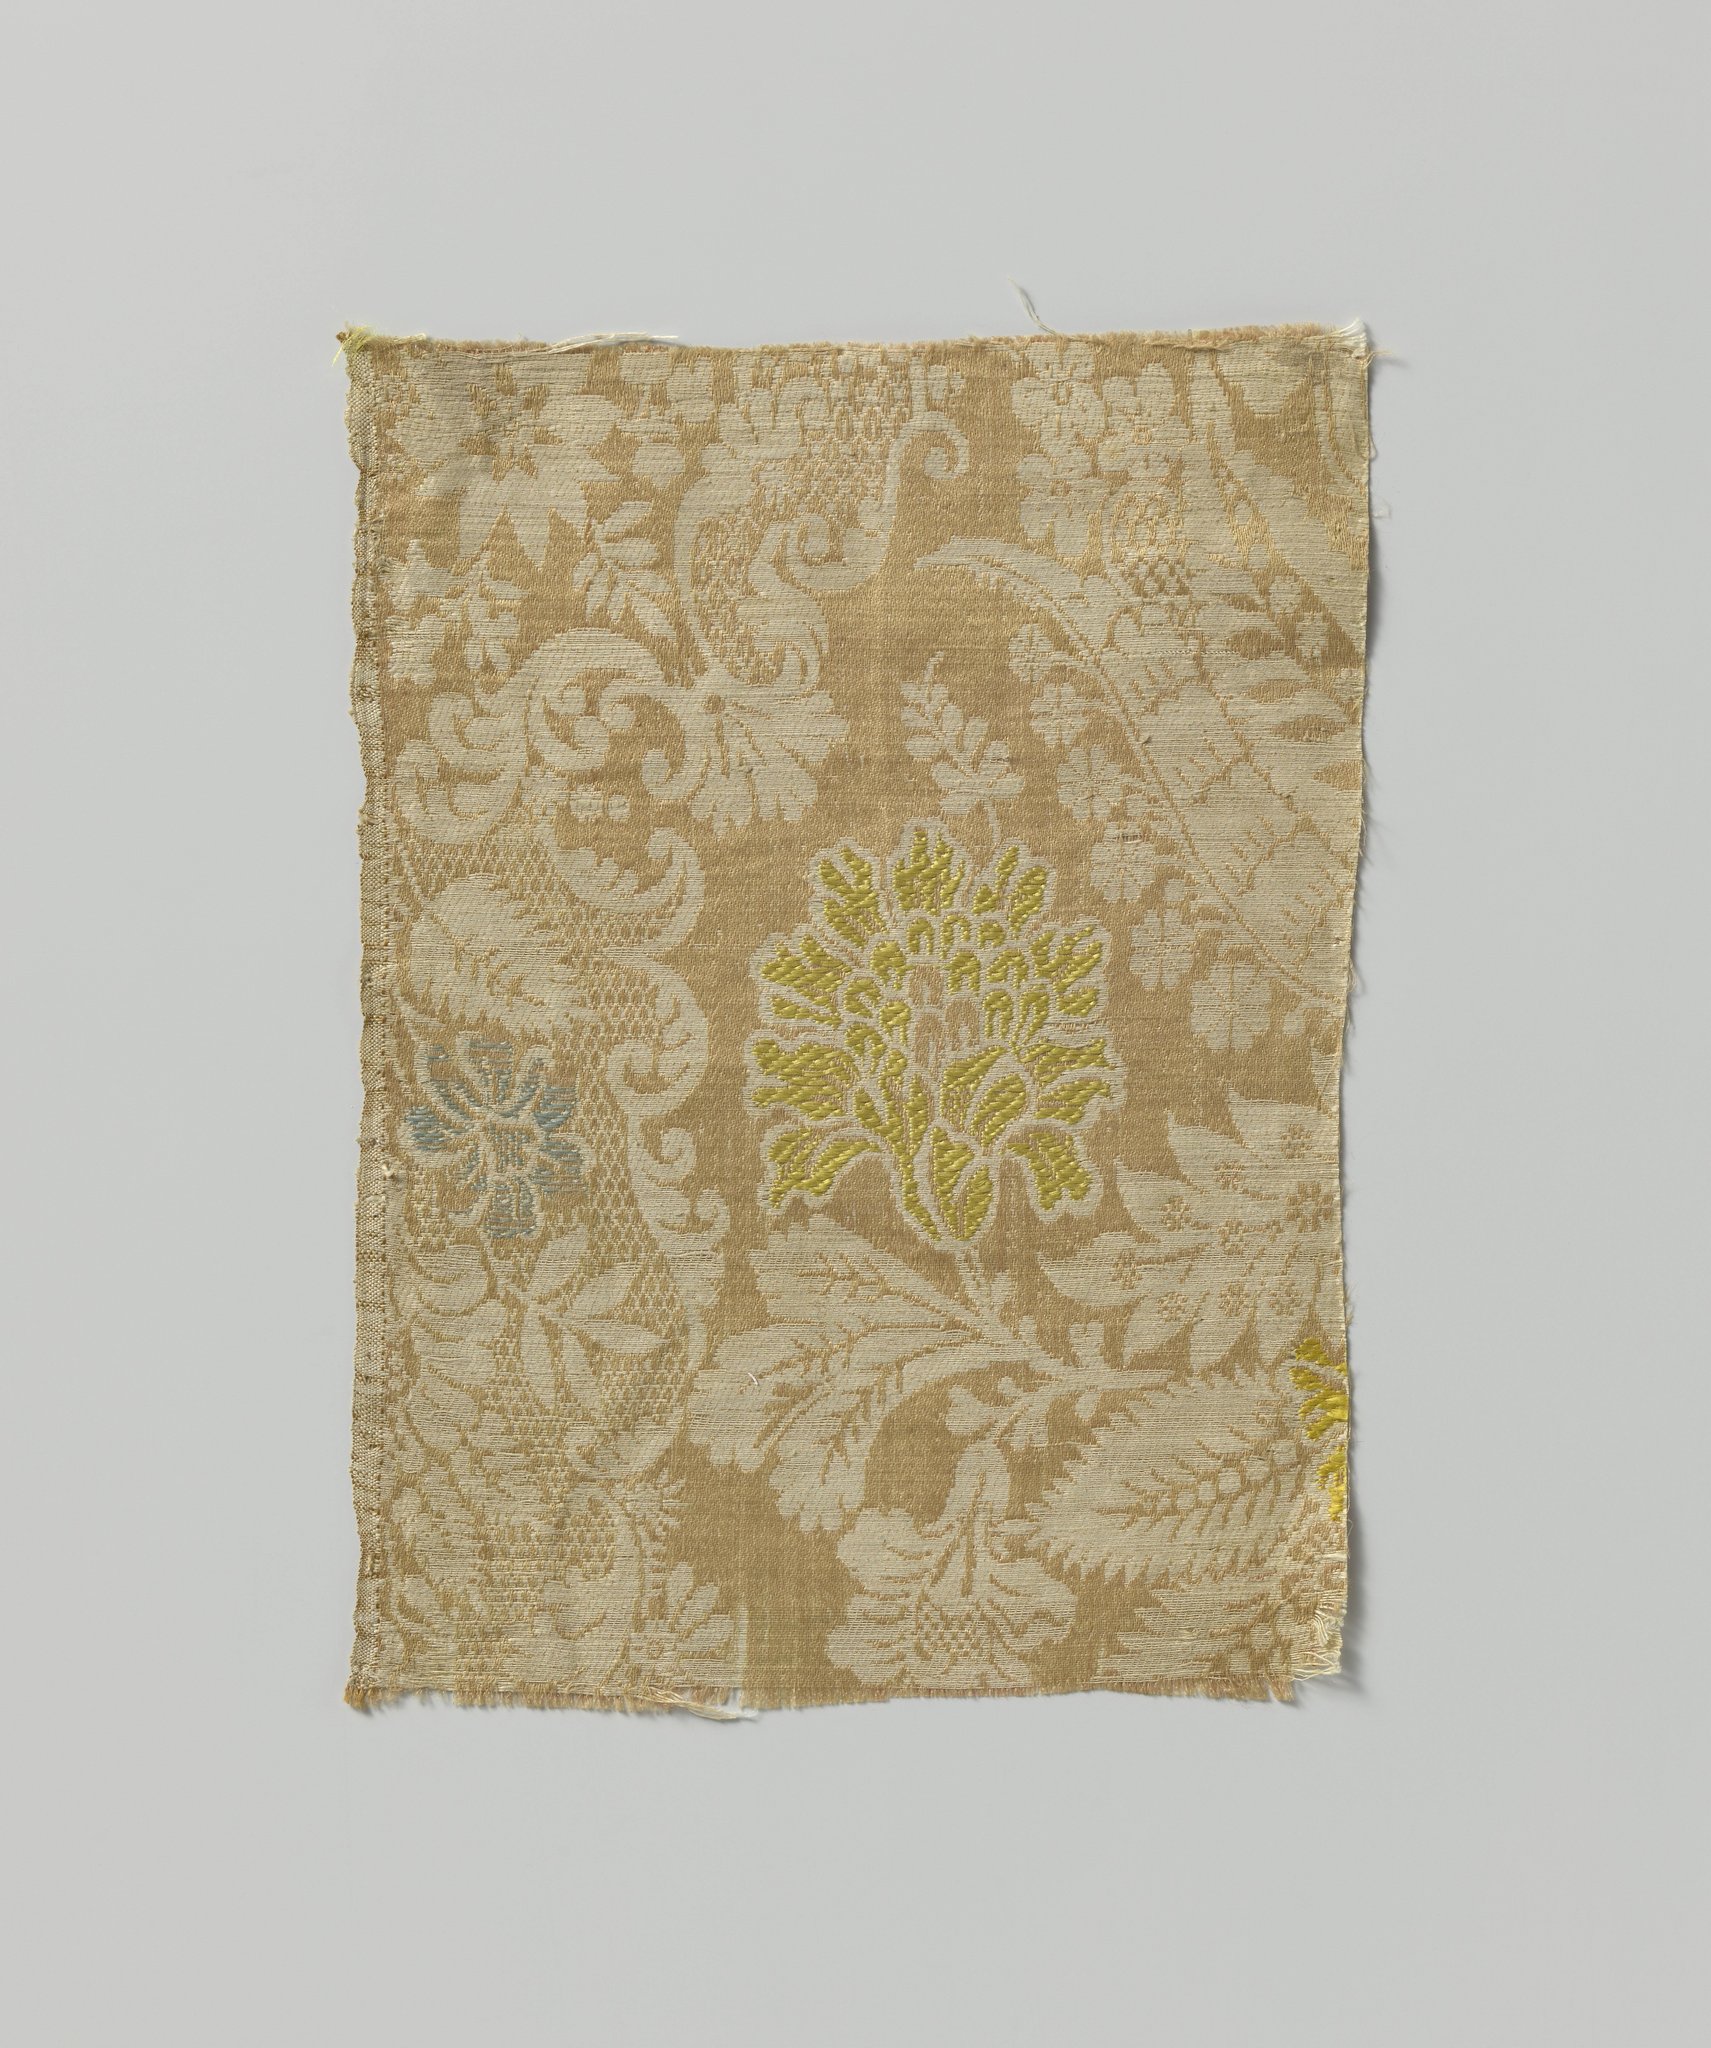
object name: zijdedamast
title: Fragment veelkleurig zijdedamast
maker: Anonymous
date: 1730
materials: cotton, silk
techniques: brocade, damask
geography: france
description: Een fragment van geelachtig wit zijdeweefsel, met gekleurde bloemen.